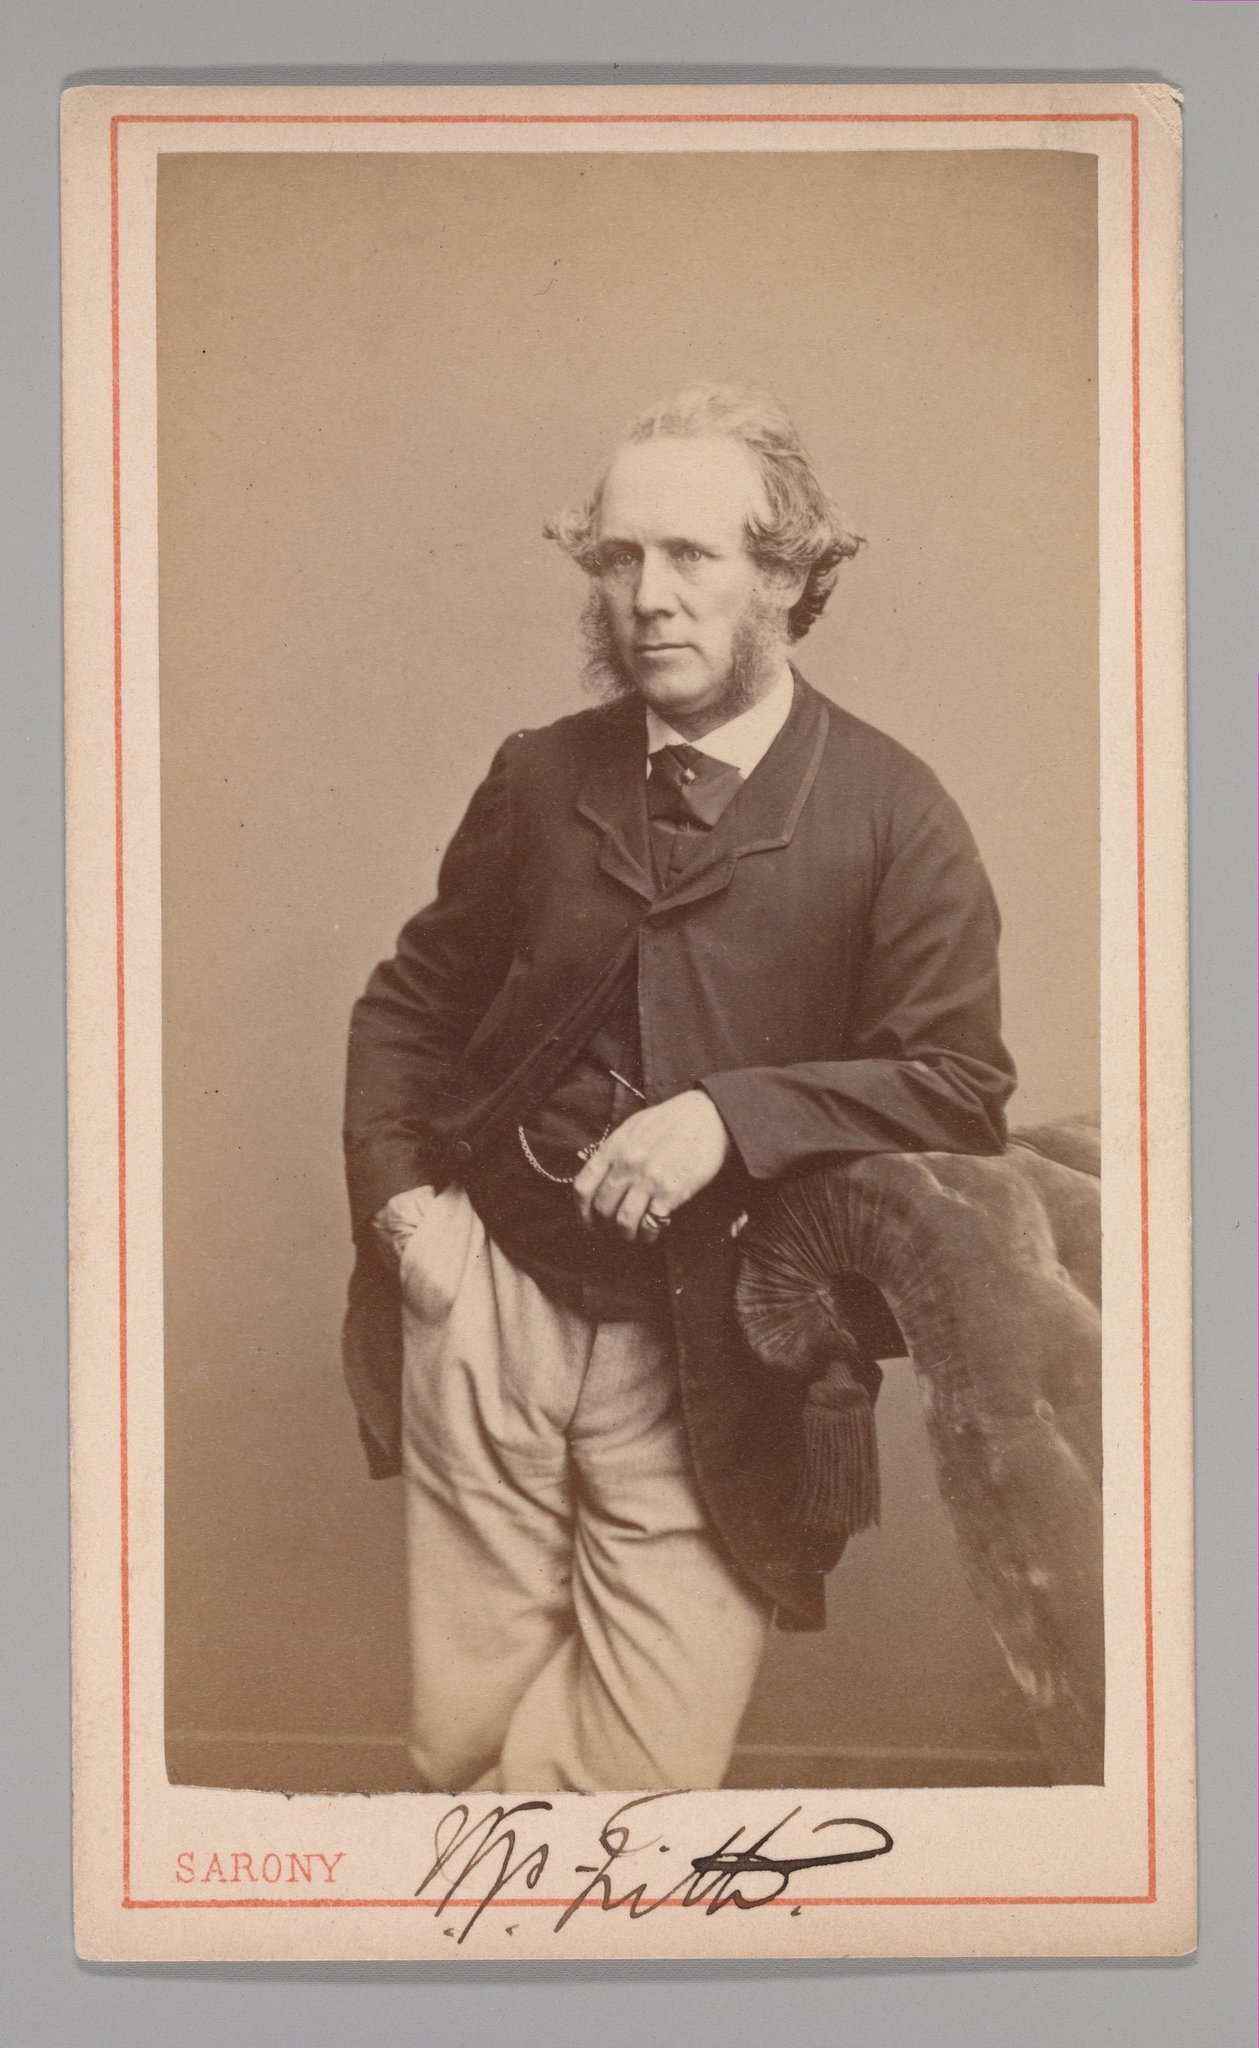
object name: carte de visite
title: [William Powell Frith]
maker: oliver françois xavier sarony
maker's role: artist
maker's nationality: canadian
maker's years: 1820-1879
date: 1860-1869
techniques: albumen silver print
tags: men,portraits